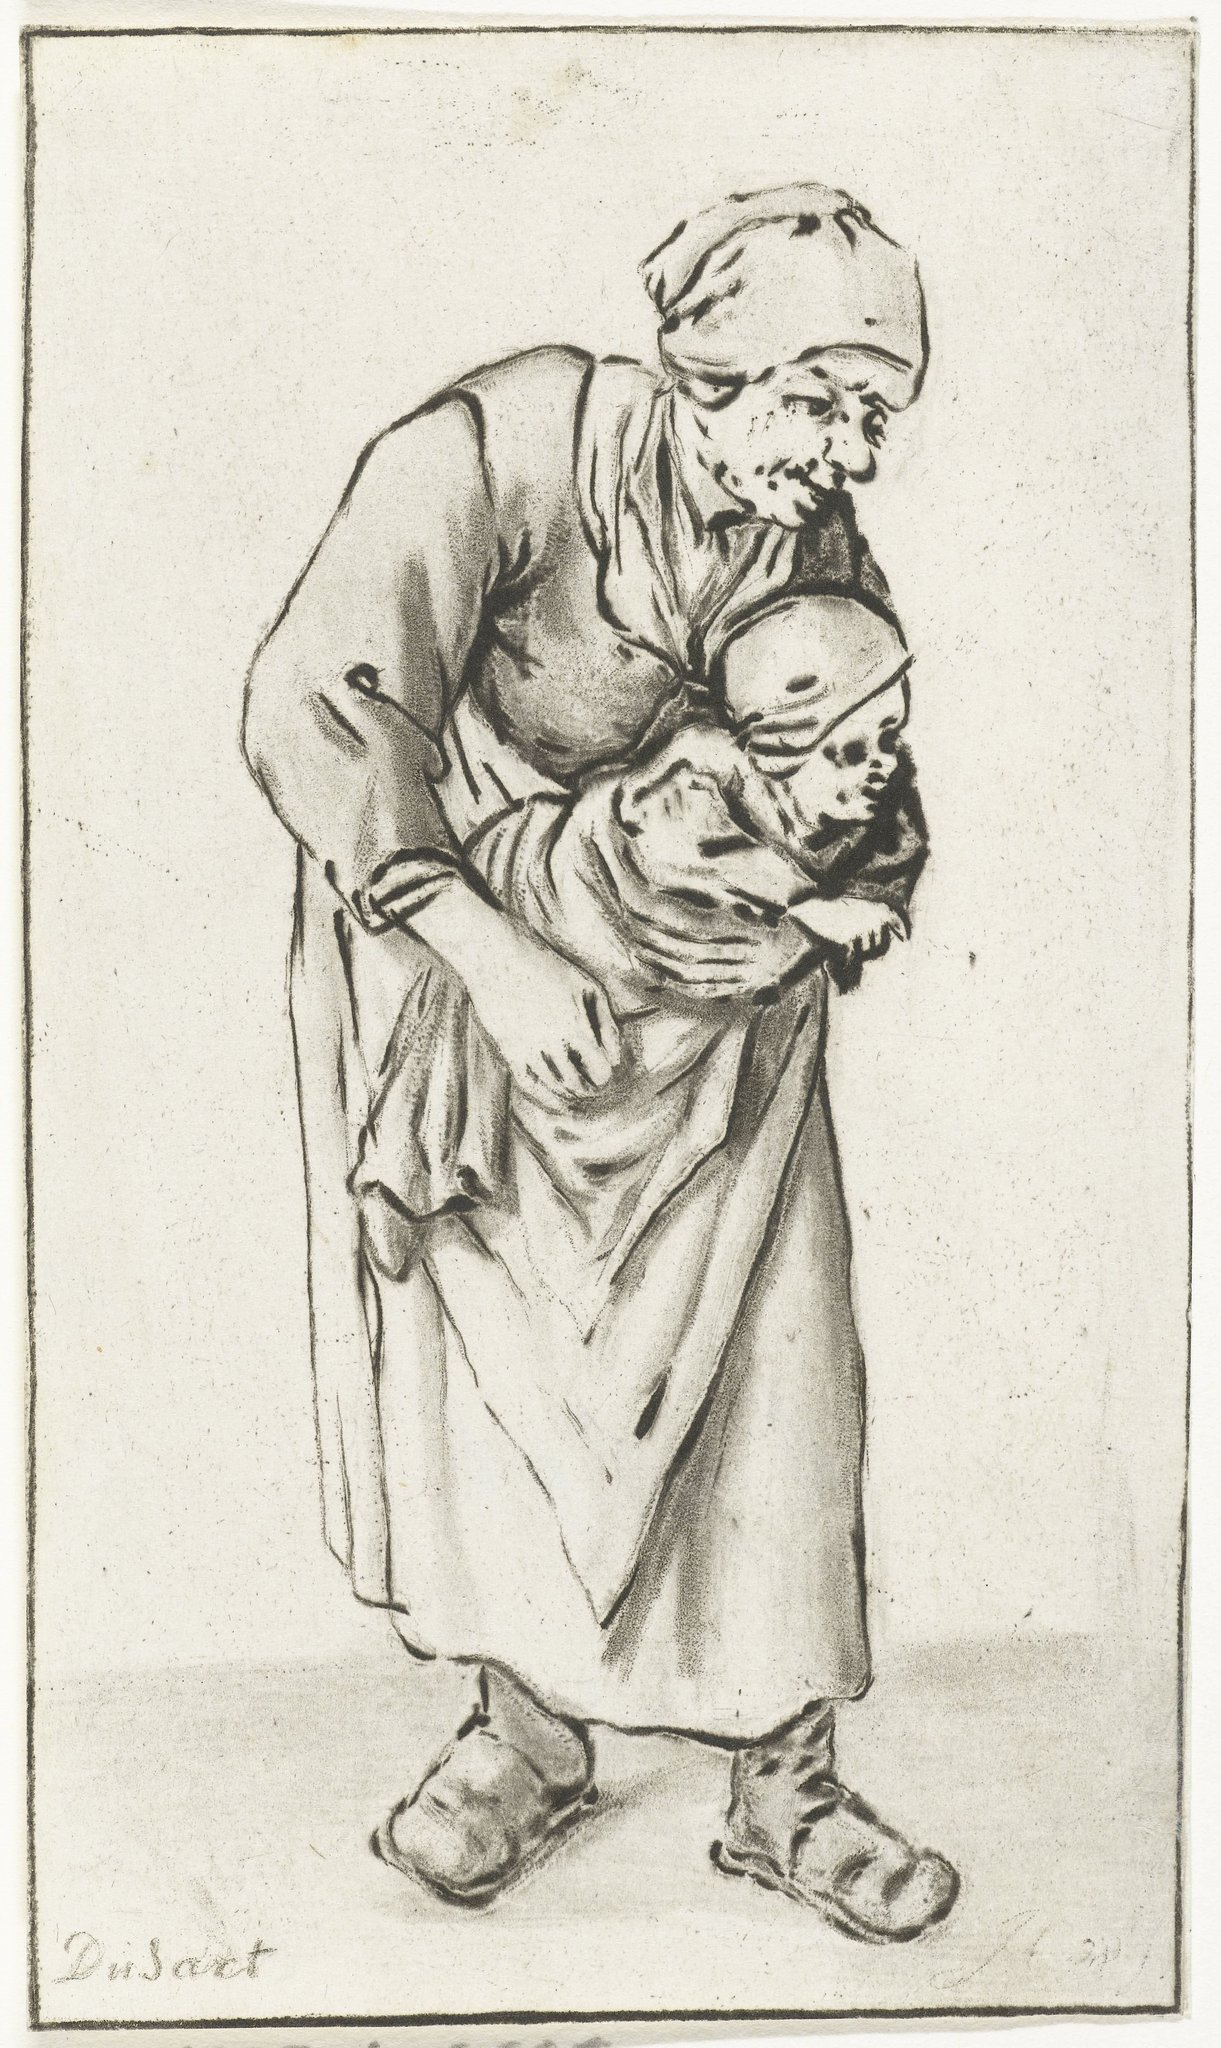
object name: print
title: Vrouw met kind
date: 1724-1798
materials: paper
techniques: print drawing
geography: amsterdam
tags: mother and child(ren), woman and child(ren) (family group)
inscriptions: collector's mark: Lugt 2228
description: Een oude vrouw. In haar armen draagt ze een baby.